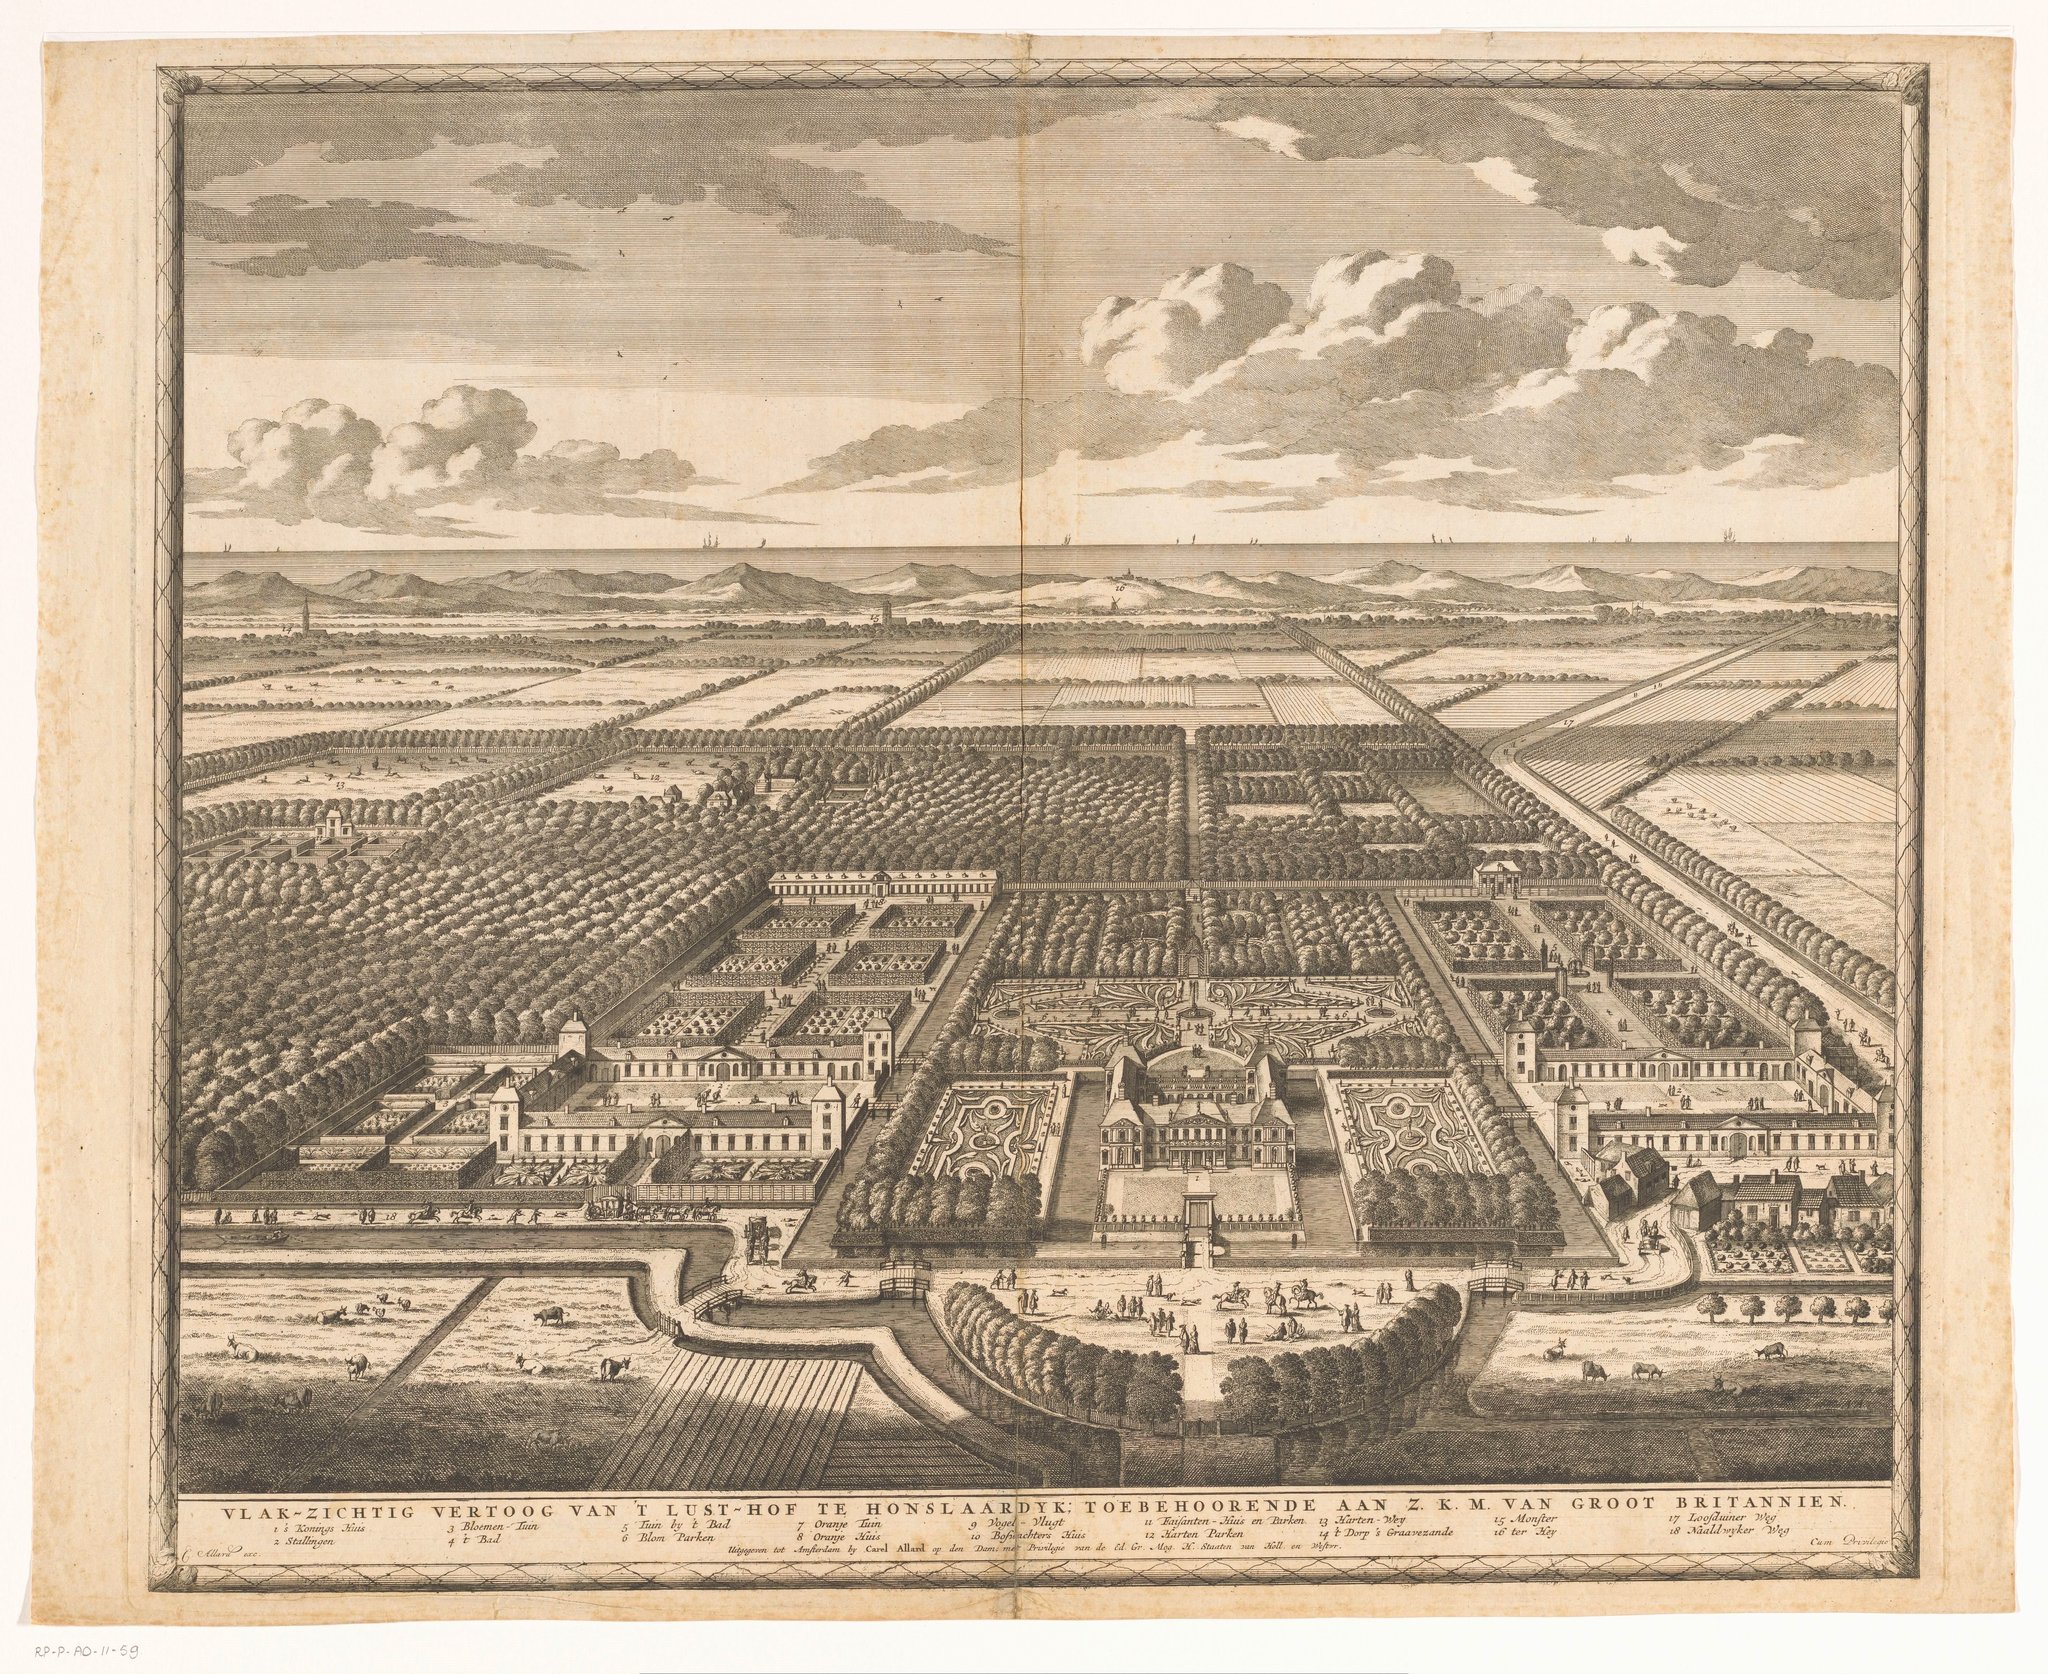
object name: print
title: Vlak-zichtig vertoog van 't Lust-Hof te Honslaardyk; toebehoorende aan Z. K. M. van Groot Britannien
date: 1689-1709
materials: paper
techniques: engraving, etching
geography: amsterdam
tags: palace, french or architectonic garden; formal garden, bird's eye view ~ representation of building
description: Gezicht op Paleis Honselaarsdijk en de bijhorende tuinen in vogelvlucht. Op de achtergrond de duinen en de Noordzee. Onder de titel en de legenda 1-18.